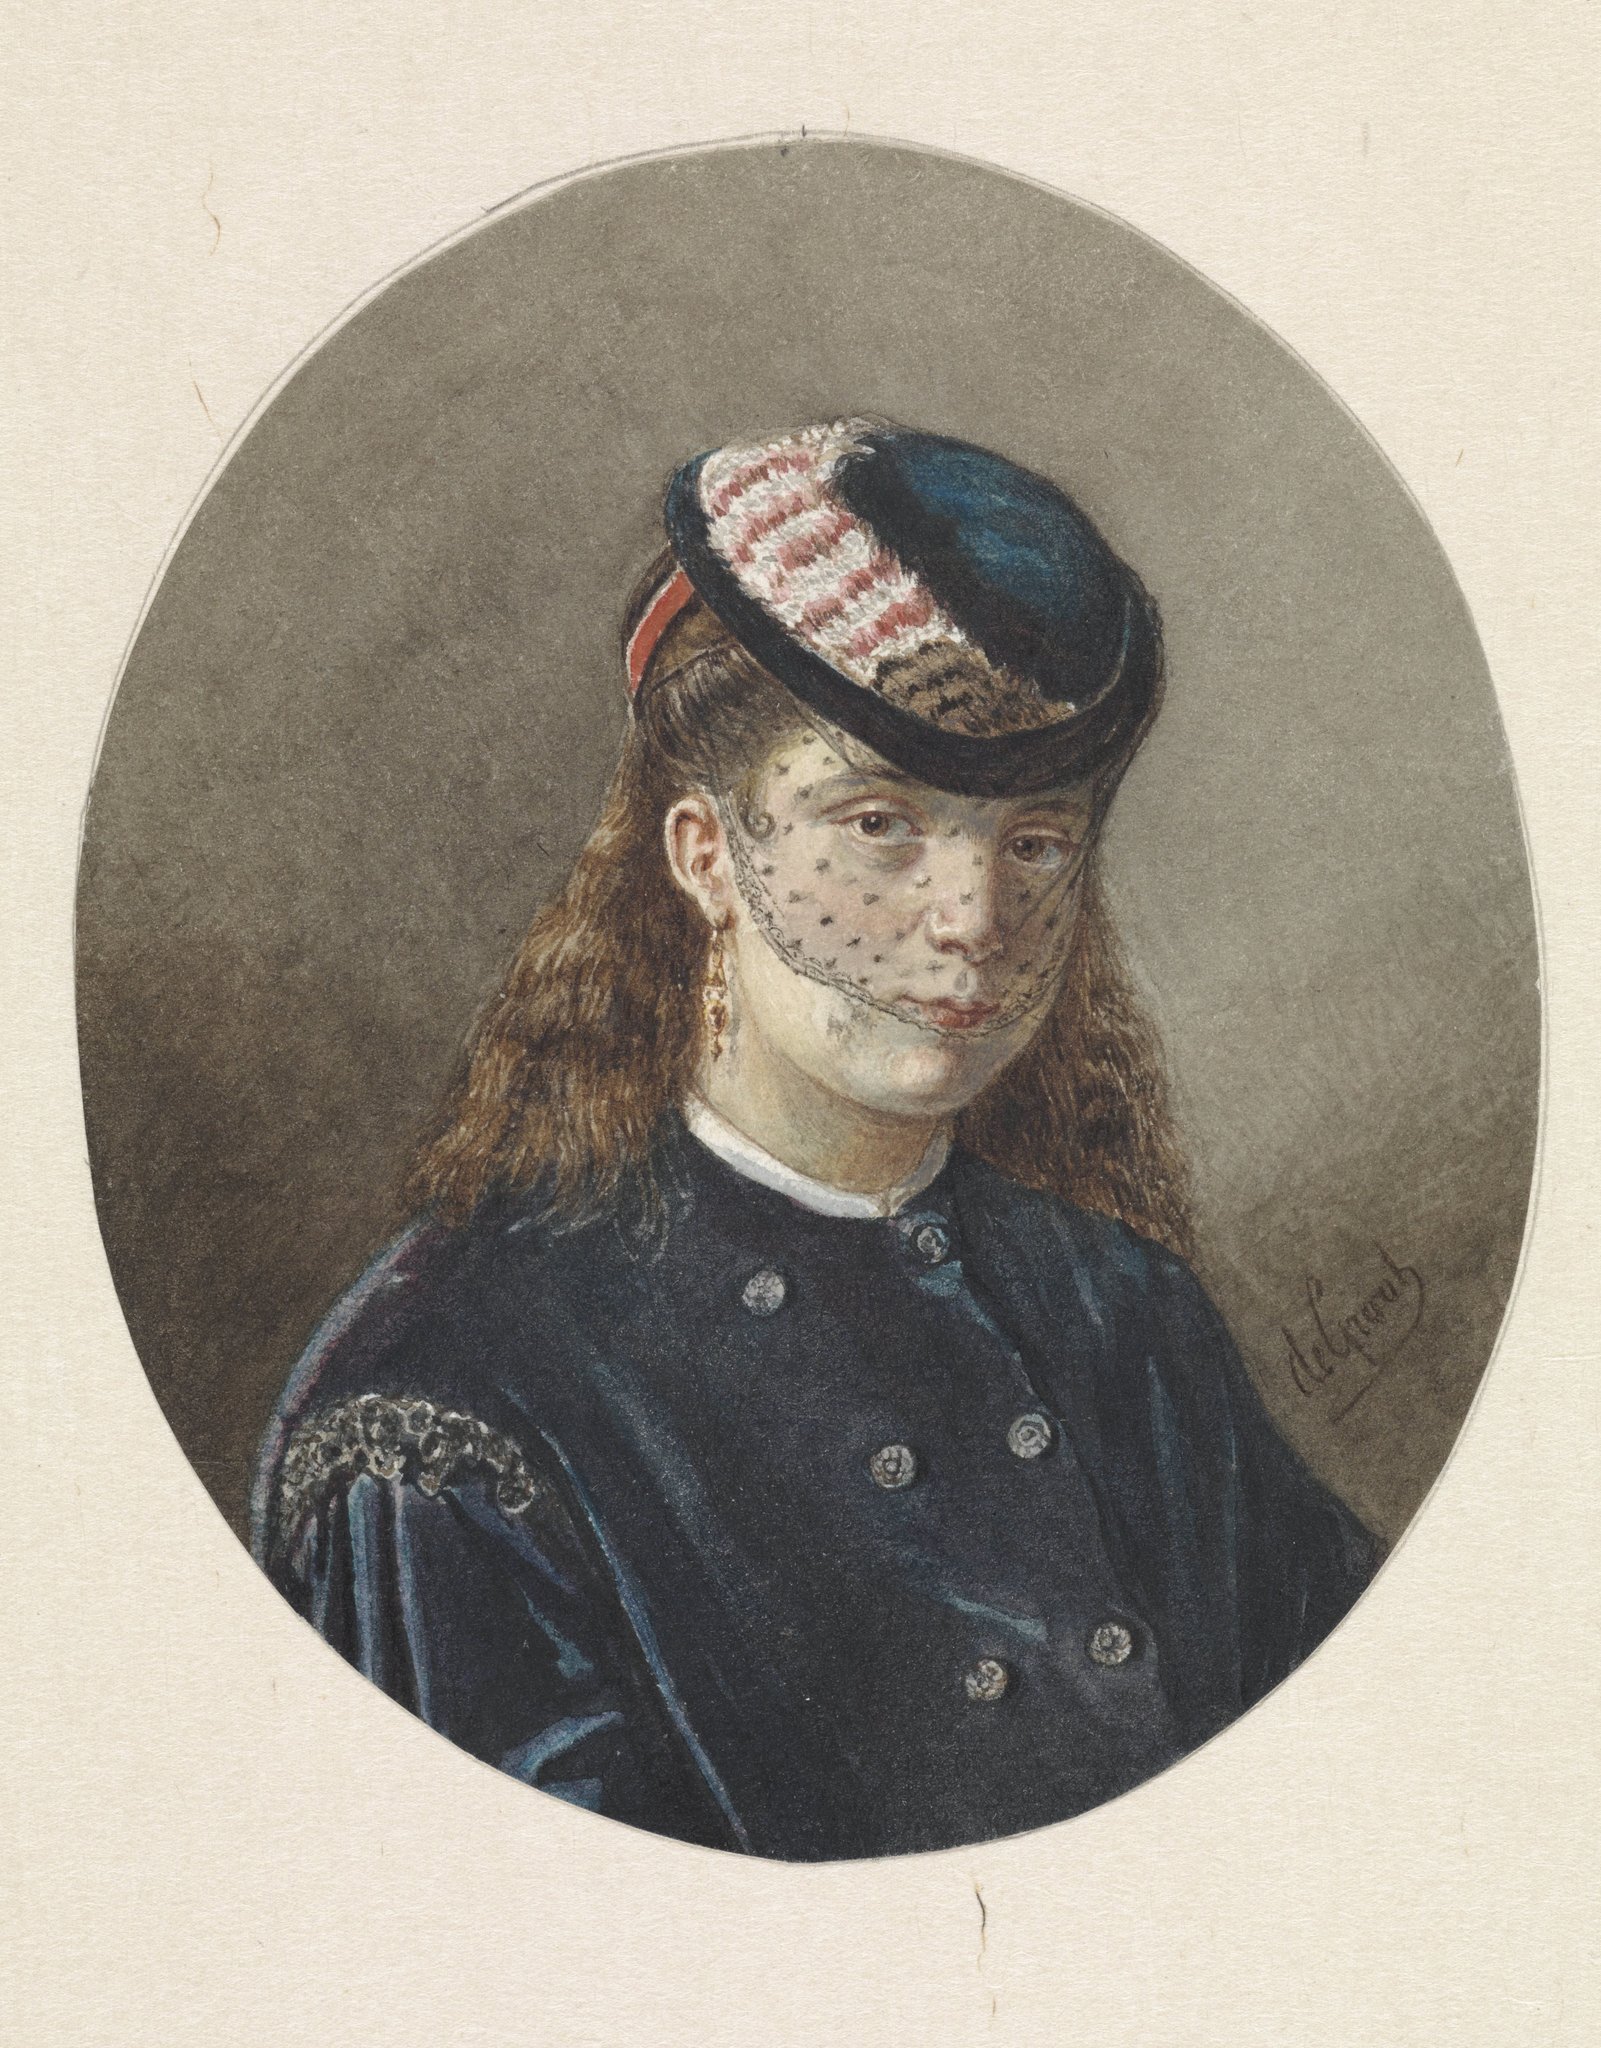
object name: watercolor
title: Portret van een jonge vrouw met hoedje met voile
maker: joseph de groot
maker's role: draughtsman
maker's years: 1828-1899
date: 1838-1899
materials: paper, watercolor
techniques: brush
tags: anonymous historical person portrayed alone